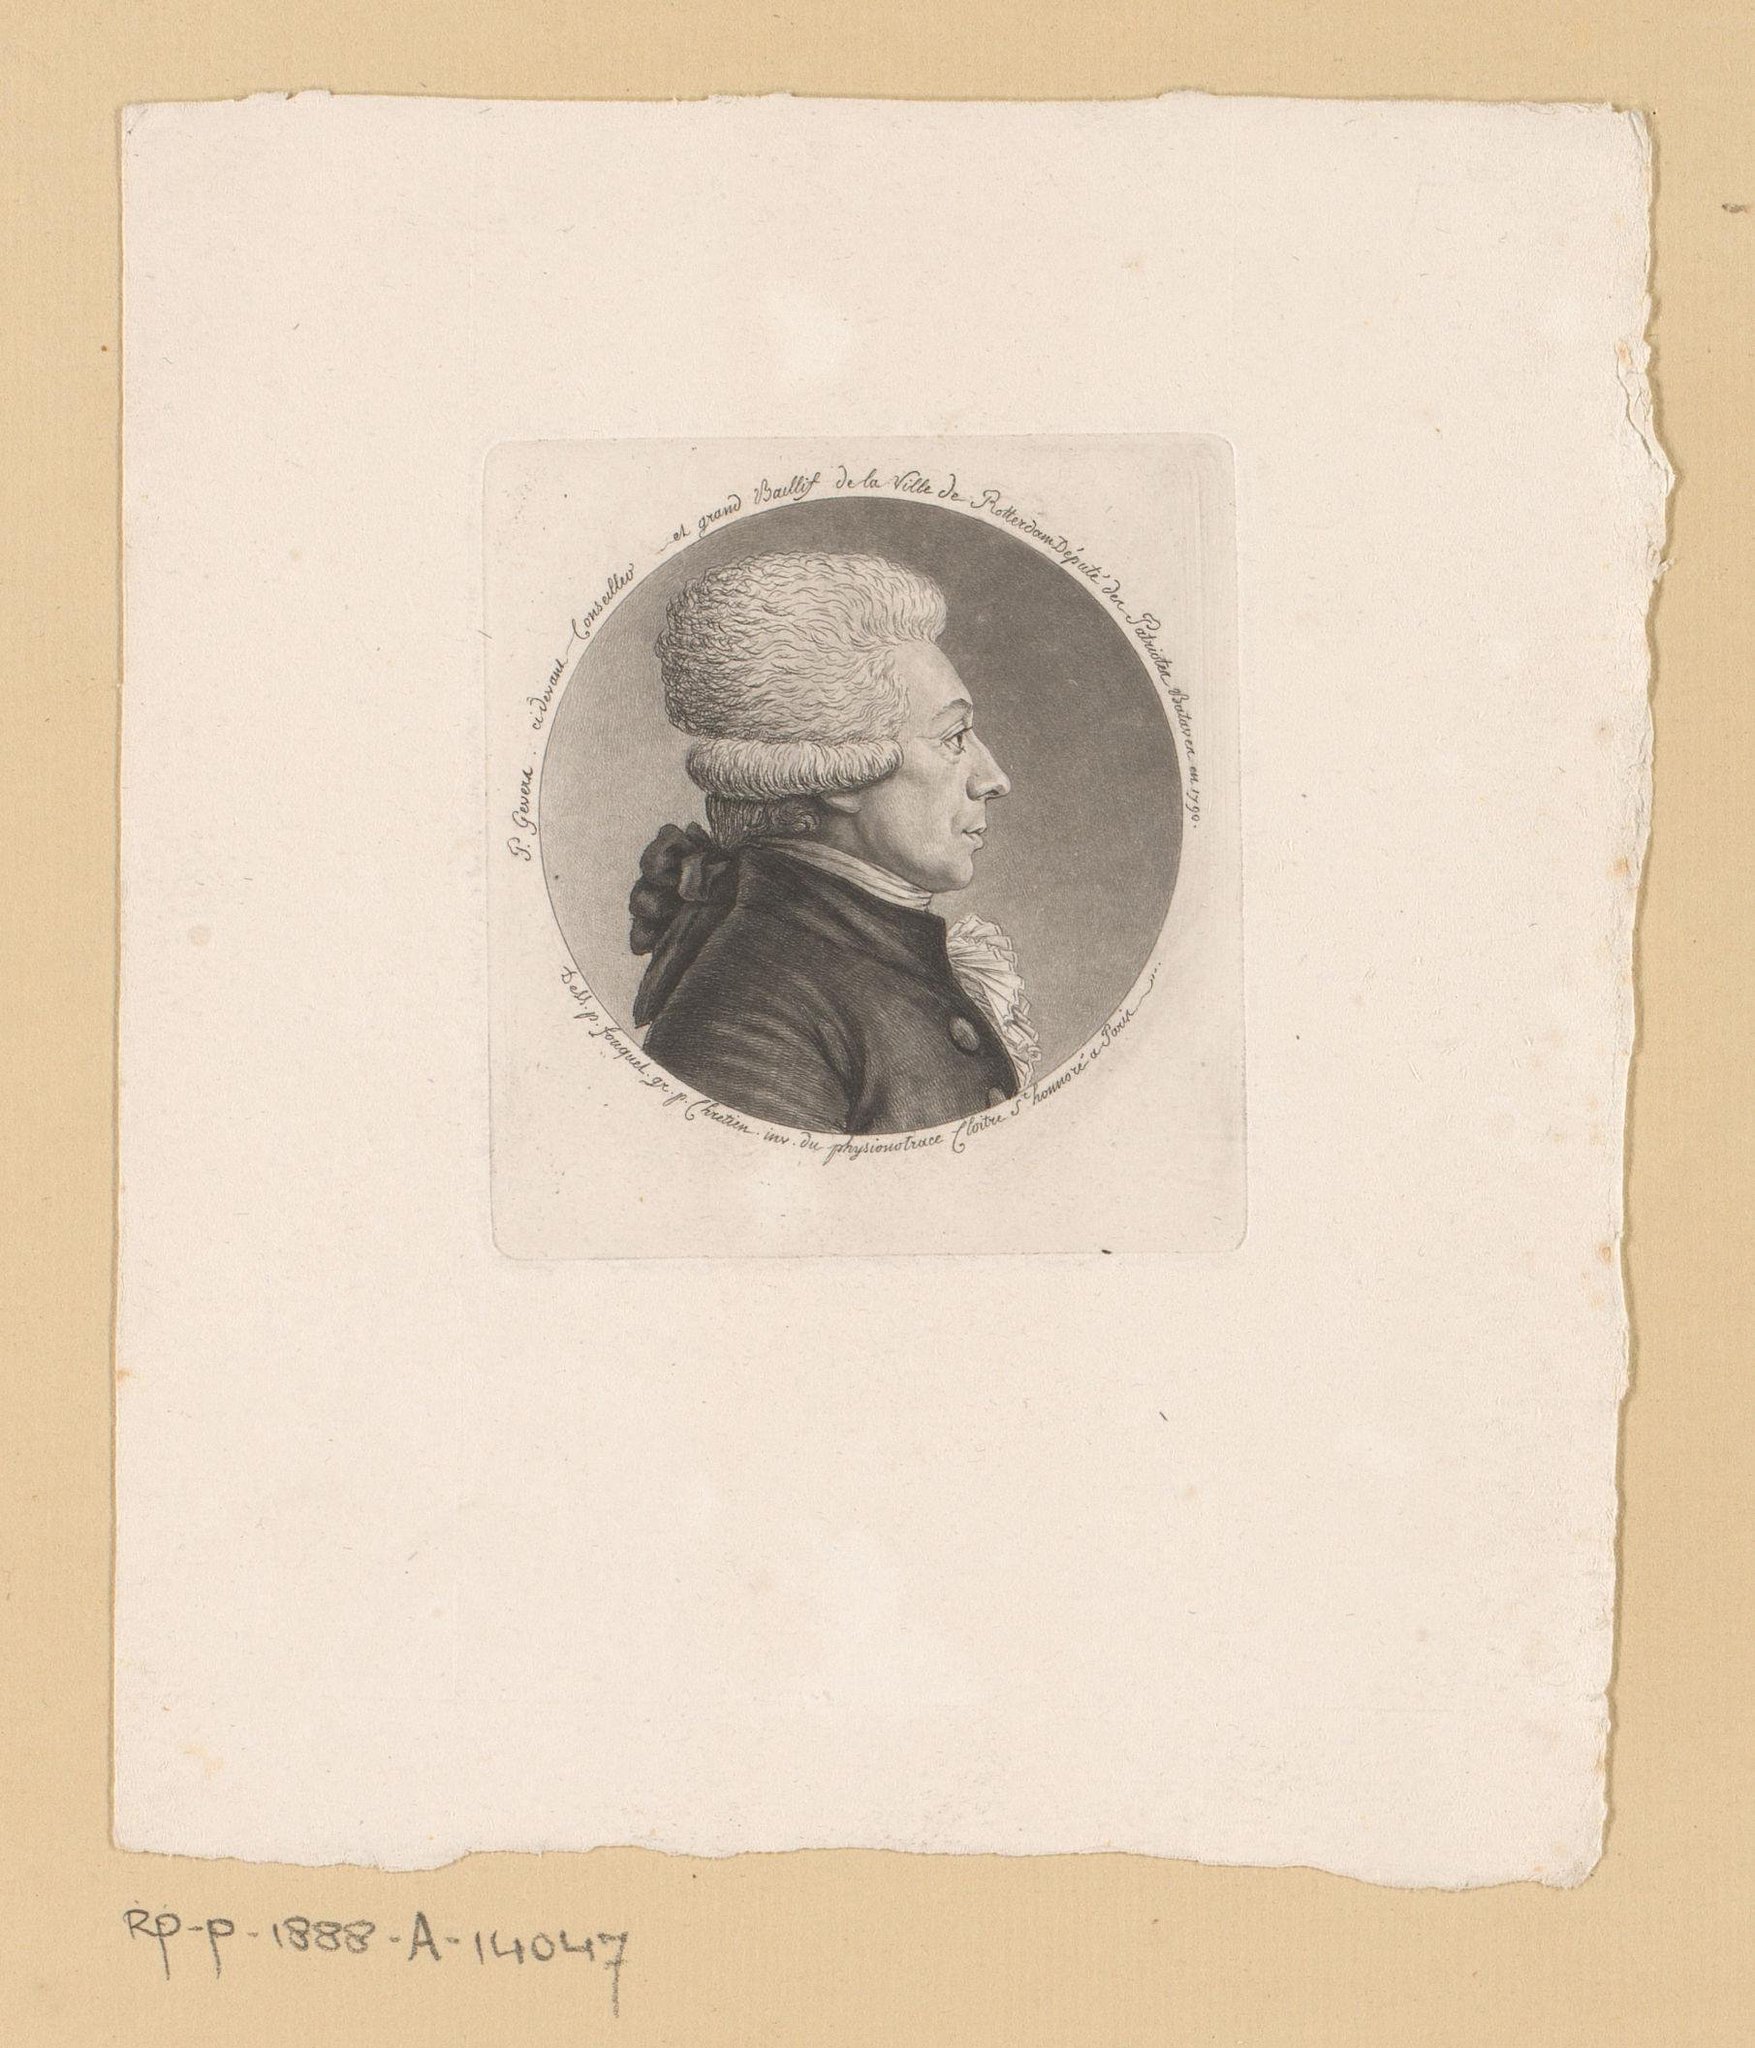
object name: print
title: P. Gevers a devant conseilleur et grand bailiff de l ville de Rotterdam député de Patriotes Bataves en 1790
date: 1790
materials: paper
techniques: aquatint, etching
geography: paris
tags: rotterdam, silhouette-apparatus, 'physionotrace', historical persons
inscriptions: collector's mark: Lugt 2227